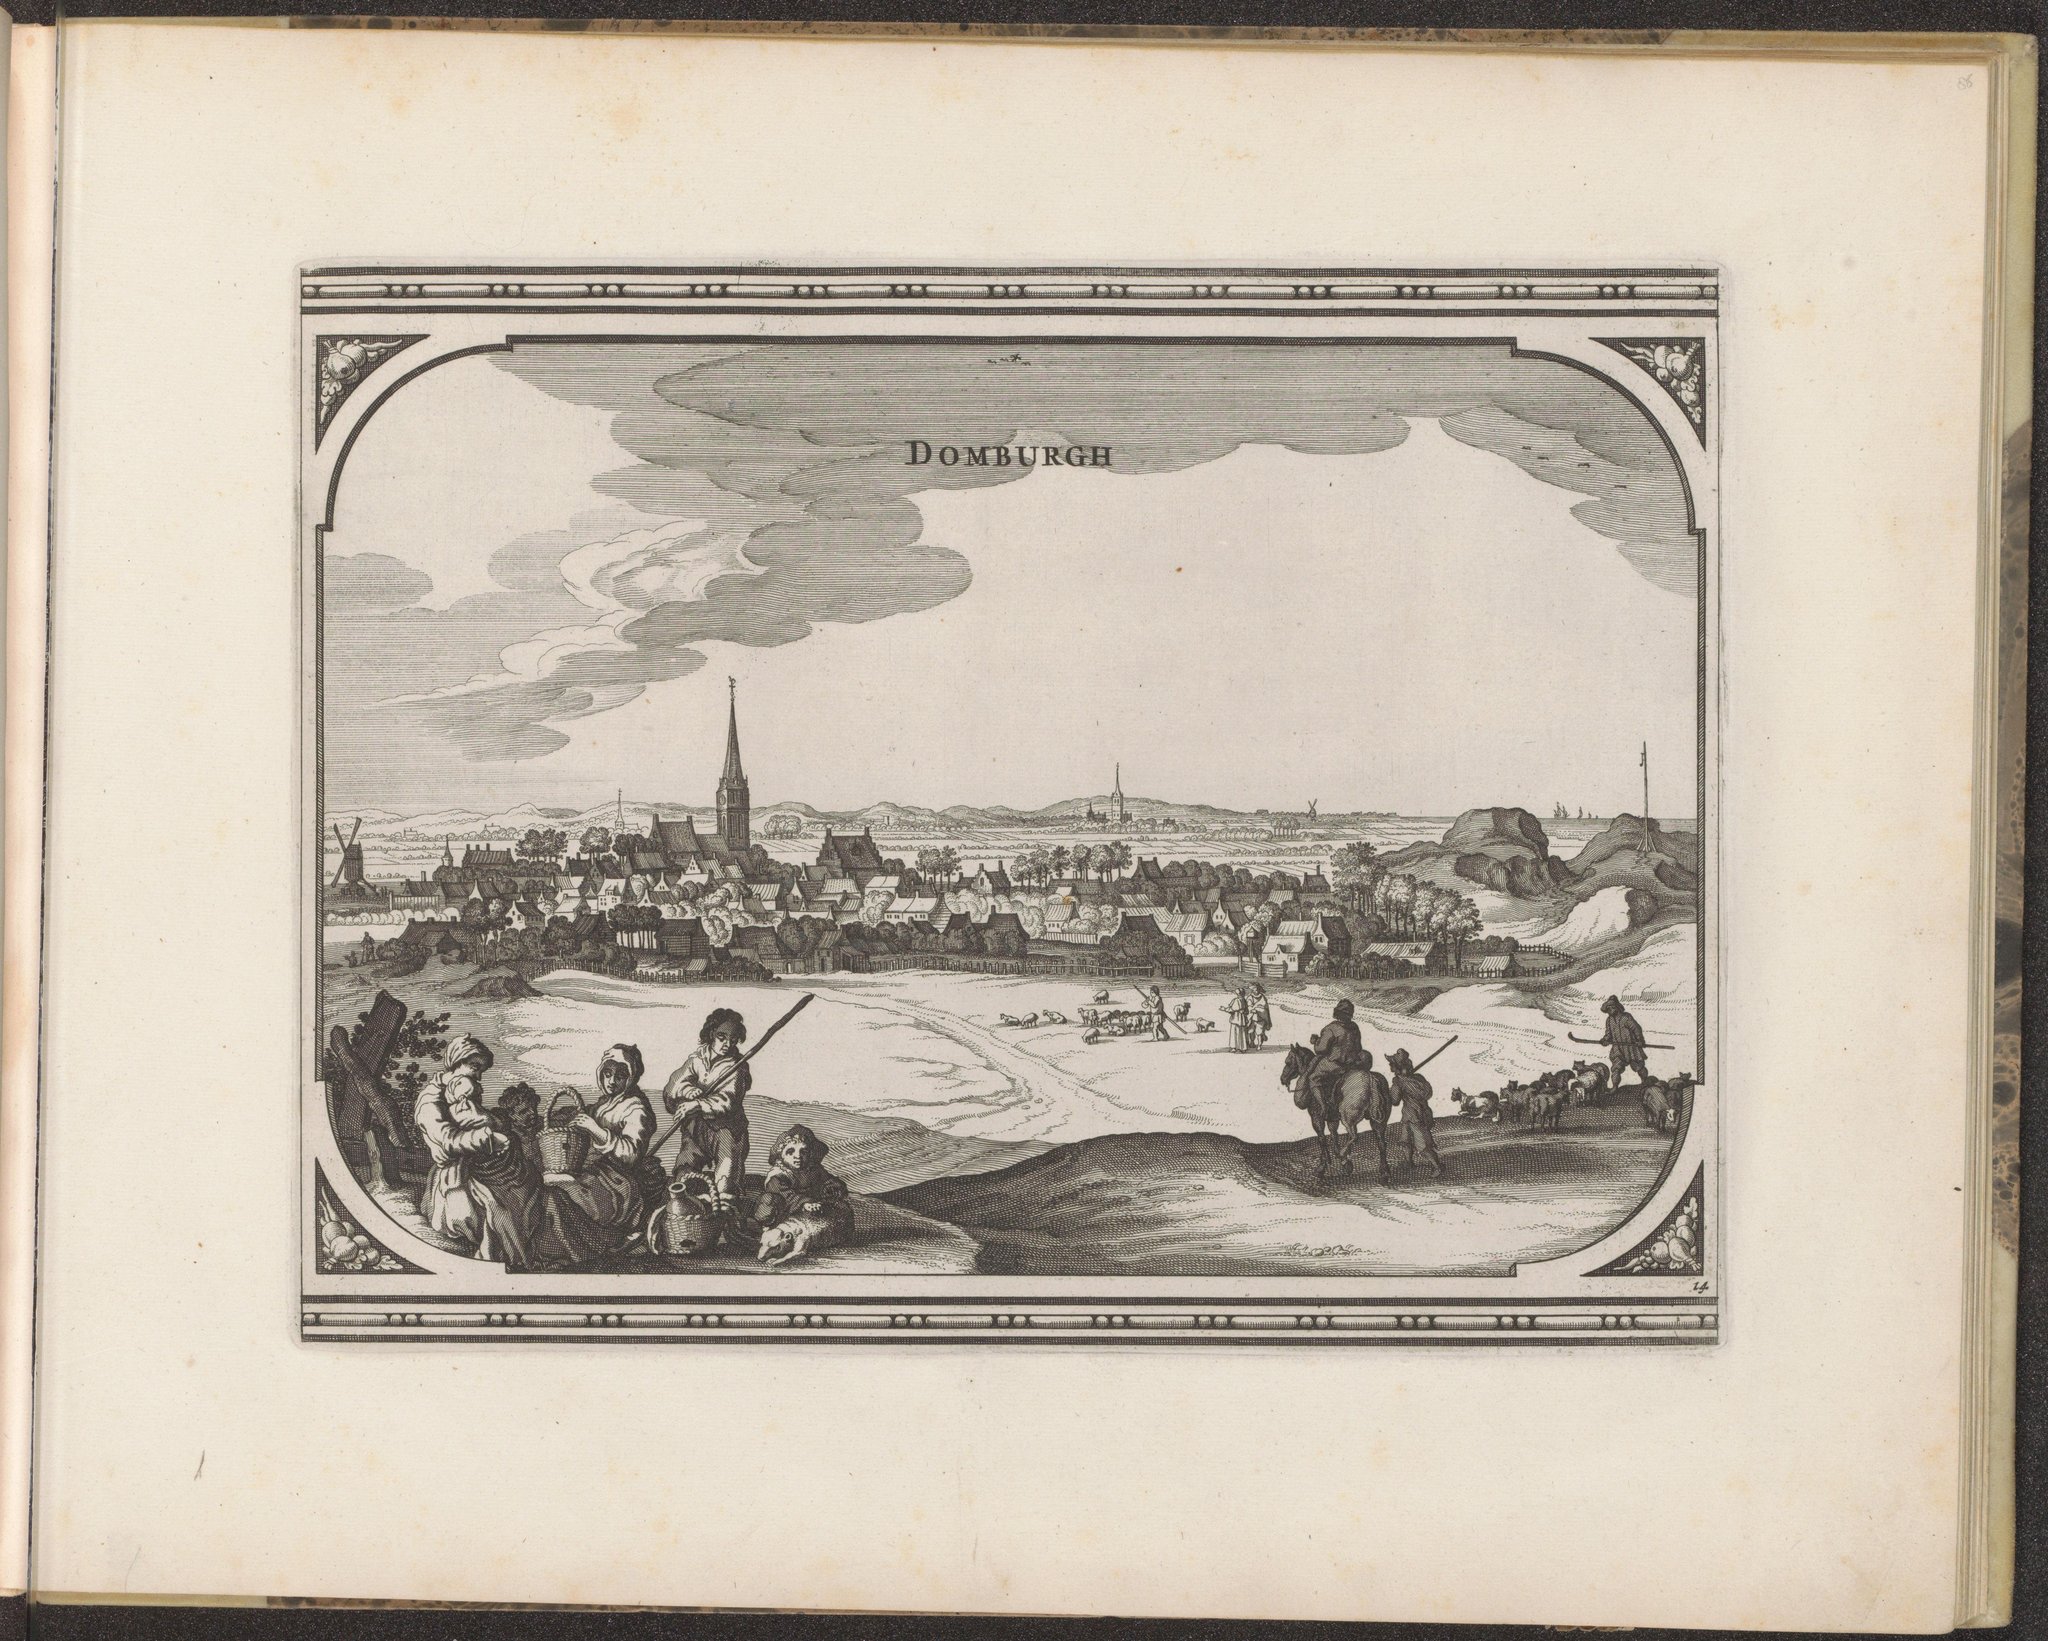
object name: print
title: Theatrum praecipuarum urbium ducatus Brabantiae necnon comitatuum Flandriae et Zelandiae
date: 1662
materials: paper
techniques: etching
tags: city-view, and landscape with man-made constructions, meadow, pasture, sitting on the ground - aa - female human figure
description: Gezicht op de stad Domburg. Links zitten twee vrouwen en enkele kinderen bij een hek. Ze hebben twee manden en een kruik bij zich. Verder twee herders, een welgesteld paar en een reiziger te paard. De prent maakt deel uit van een album.